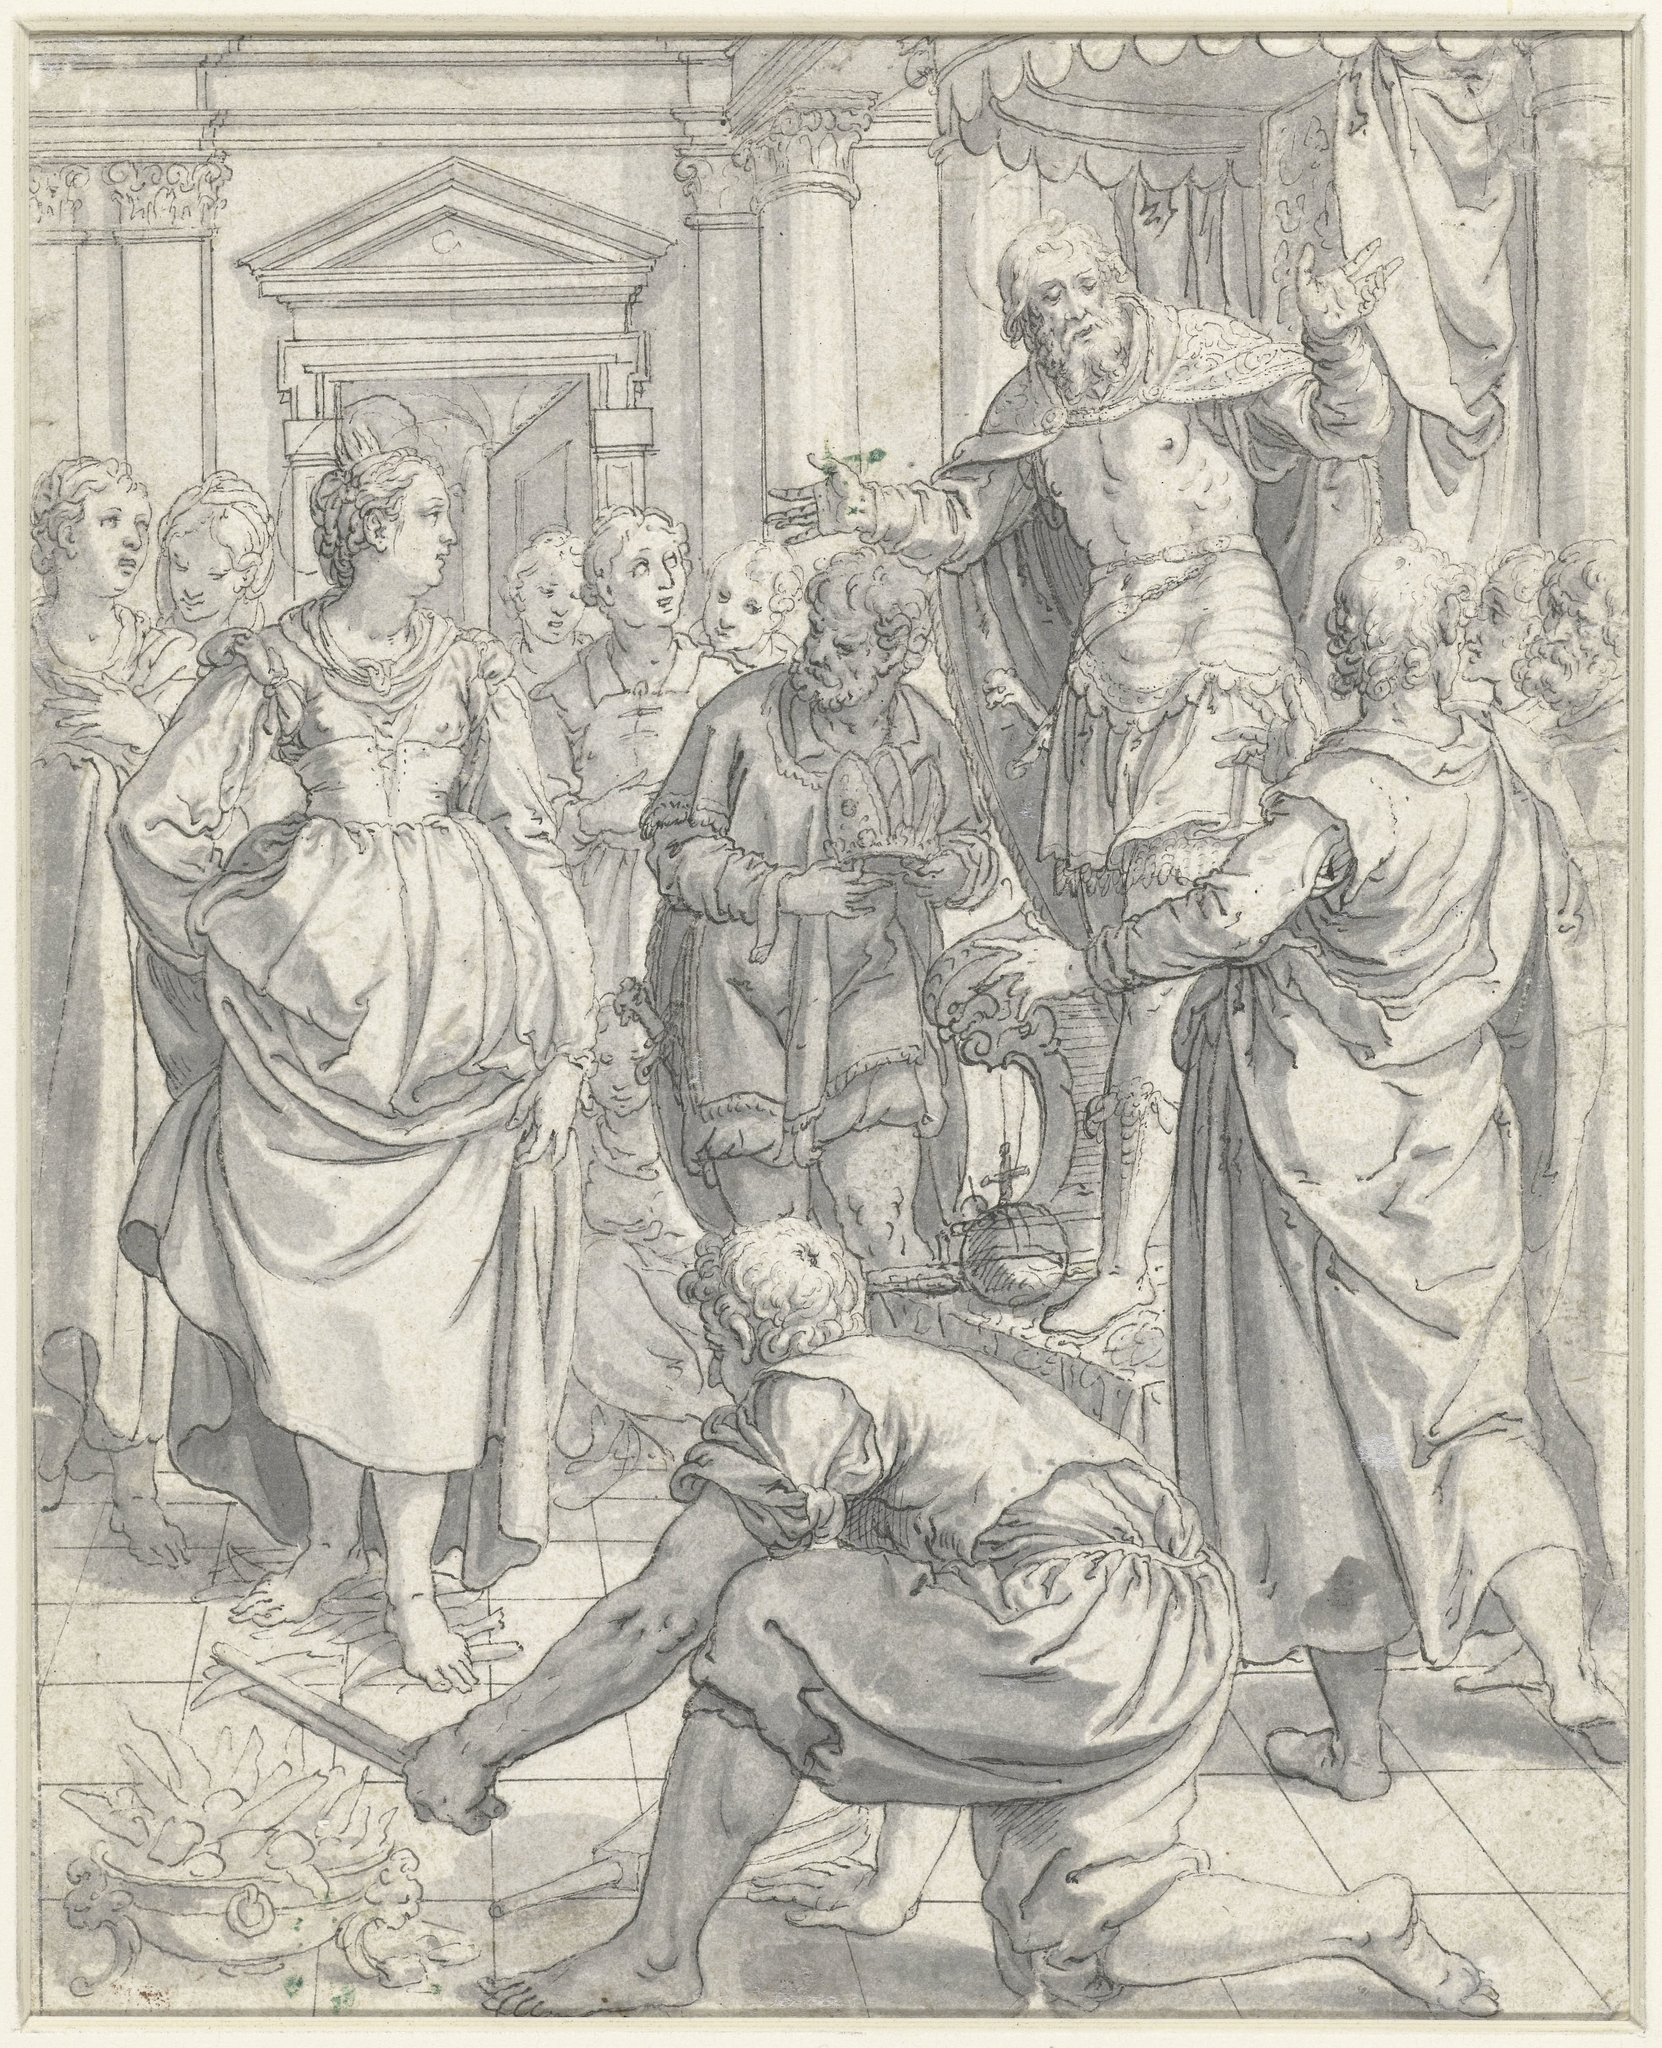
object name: drawing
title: De heilige Kunigunda bewijst haar onschuld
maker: johann mathias kager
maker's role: draughtsman, print maker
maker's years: 1575-1634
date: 1585-1634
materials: ink, paper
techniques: brush, pen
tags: the trial by ordeal of st. cunegunda: accused of marital infidelity, she walks over red-hot ploughshares unharmed; usually her husband king henry ii present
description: De heilige Kunigunda bewijst haar onschuld aan overspel door voor haar echtgenoot H. Hendrik van Duitsland over roodgloeiende ploegscharen te lopen. Ontwerp voor een prent.